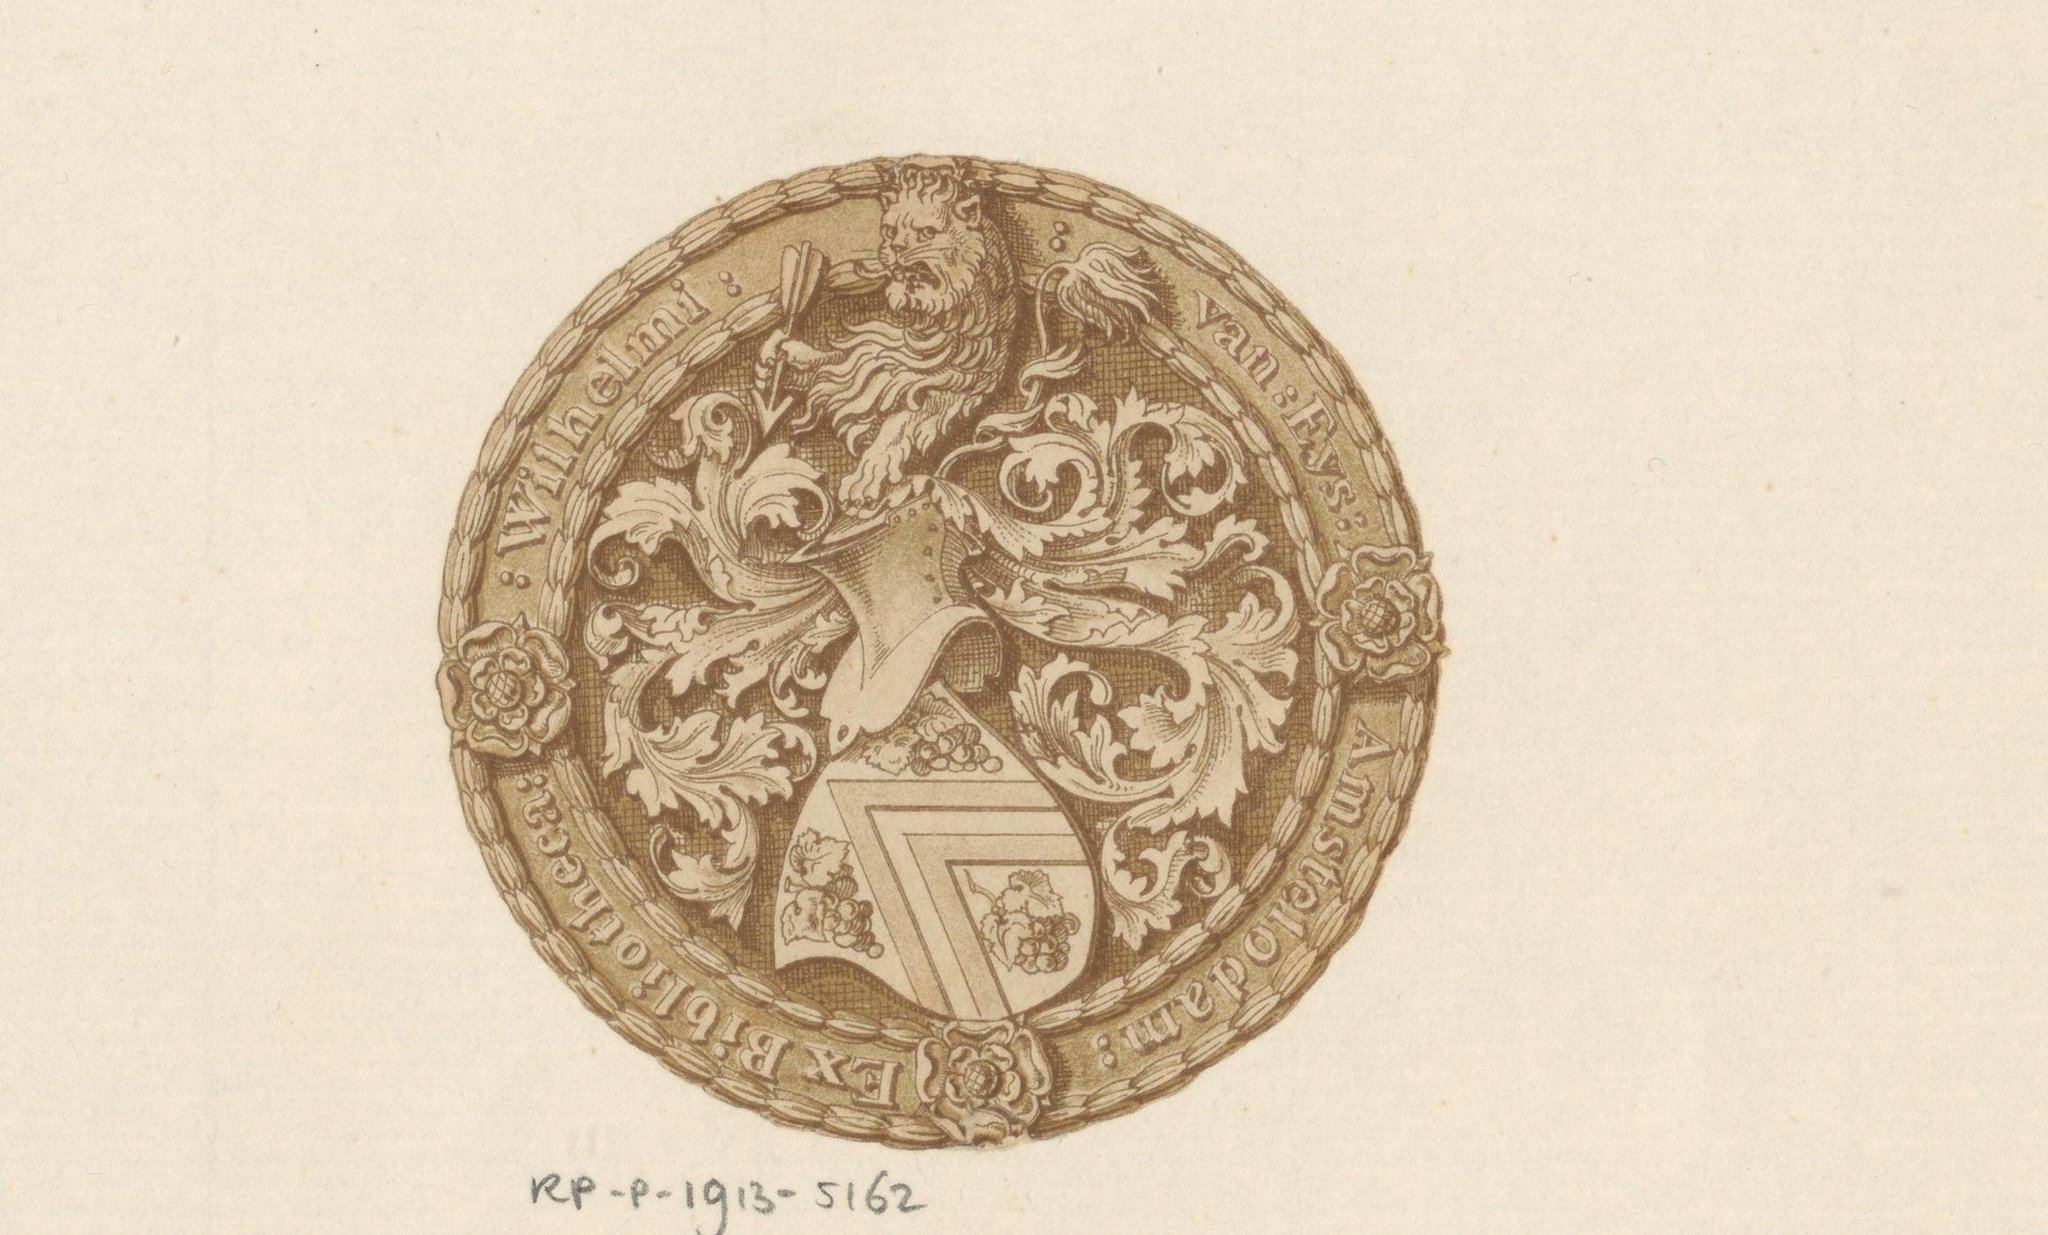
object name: bookplate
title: Ex libris van Willem Jan van Eys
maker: Anonymous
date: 1850-1913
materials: paper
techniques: photograph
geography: netherlands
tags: flowers: rose, beasts of prey, predatory animals: lion, bunch of grapes, armorial bearing, heraldry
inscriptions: collector's mark: Lugt 2760, collector's mark: Lugt 2233